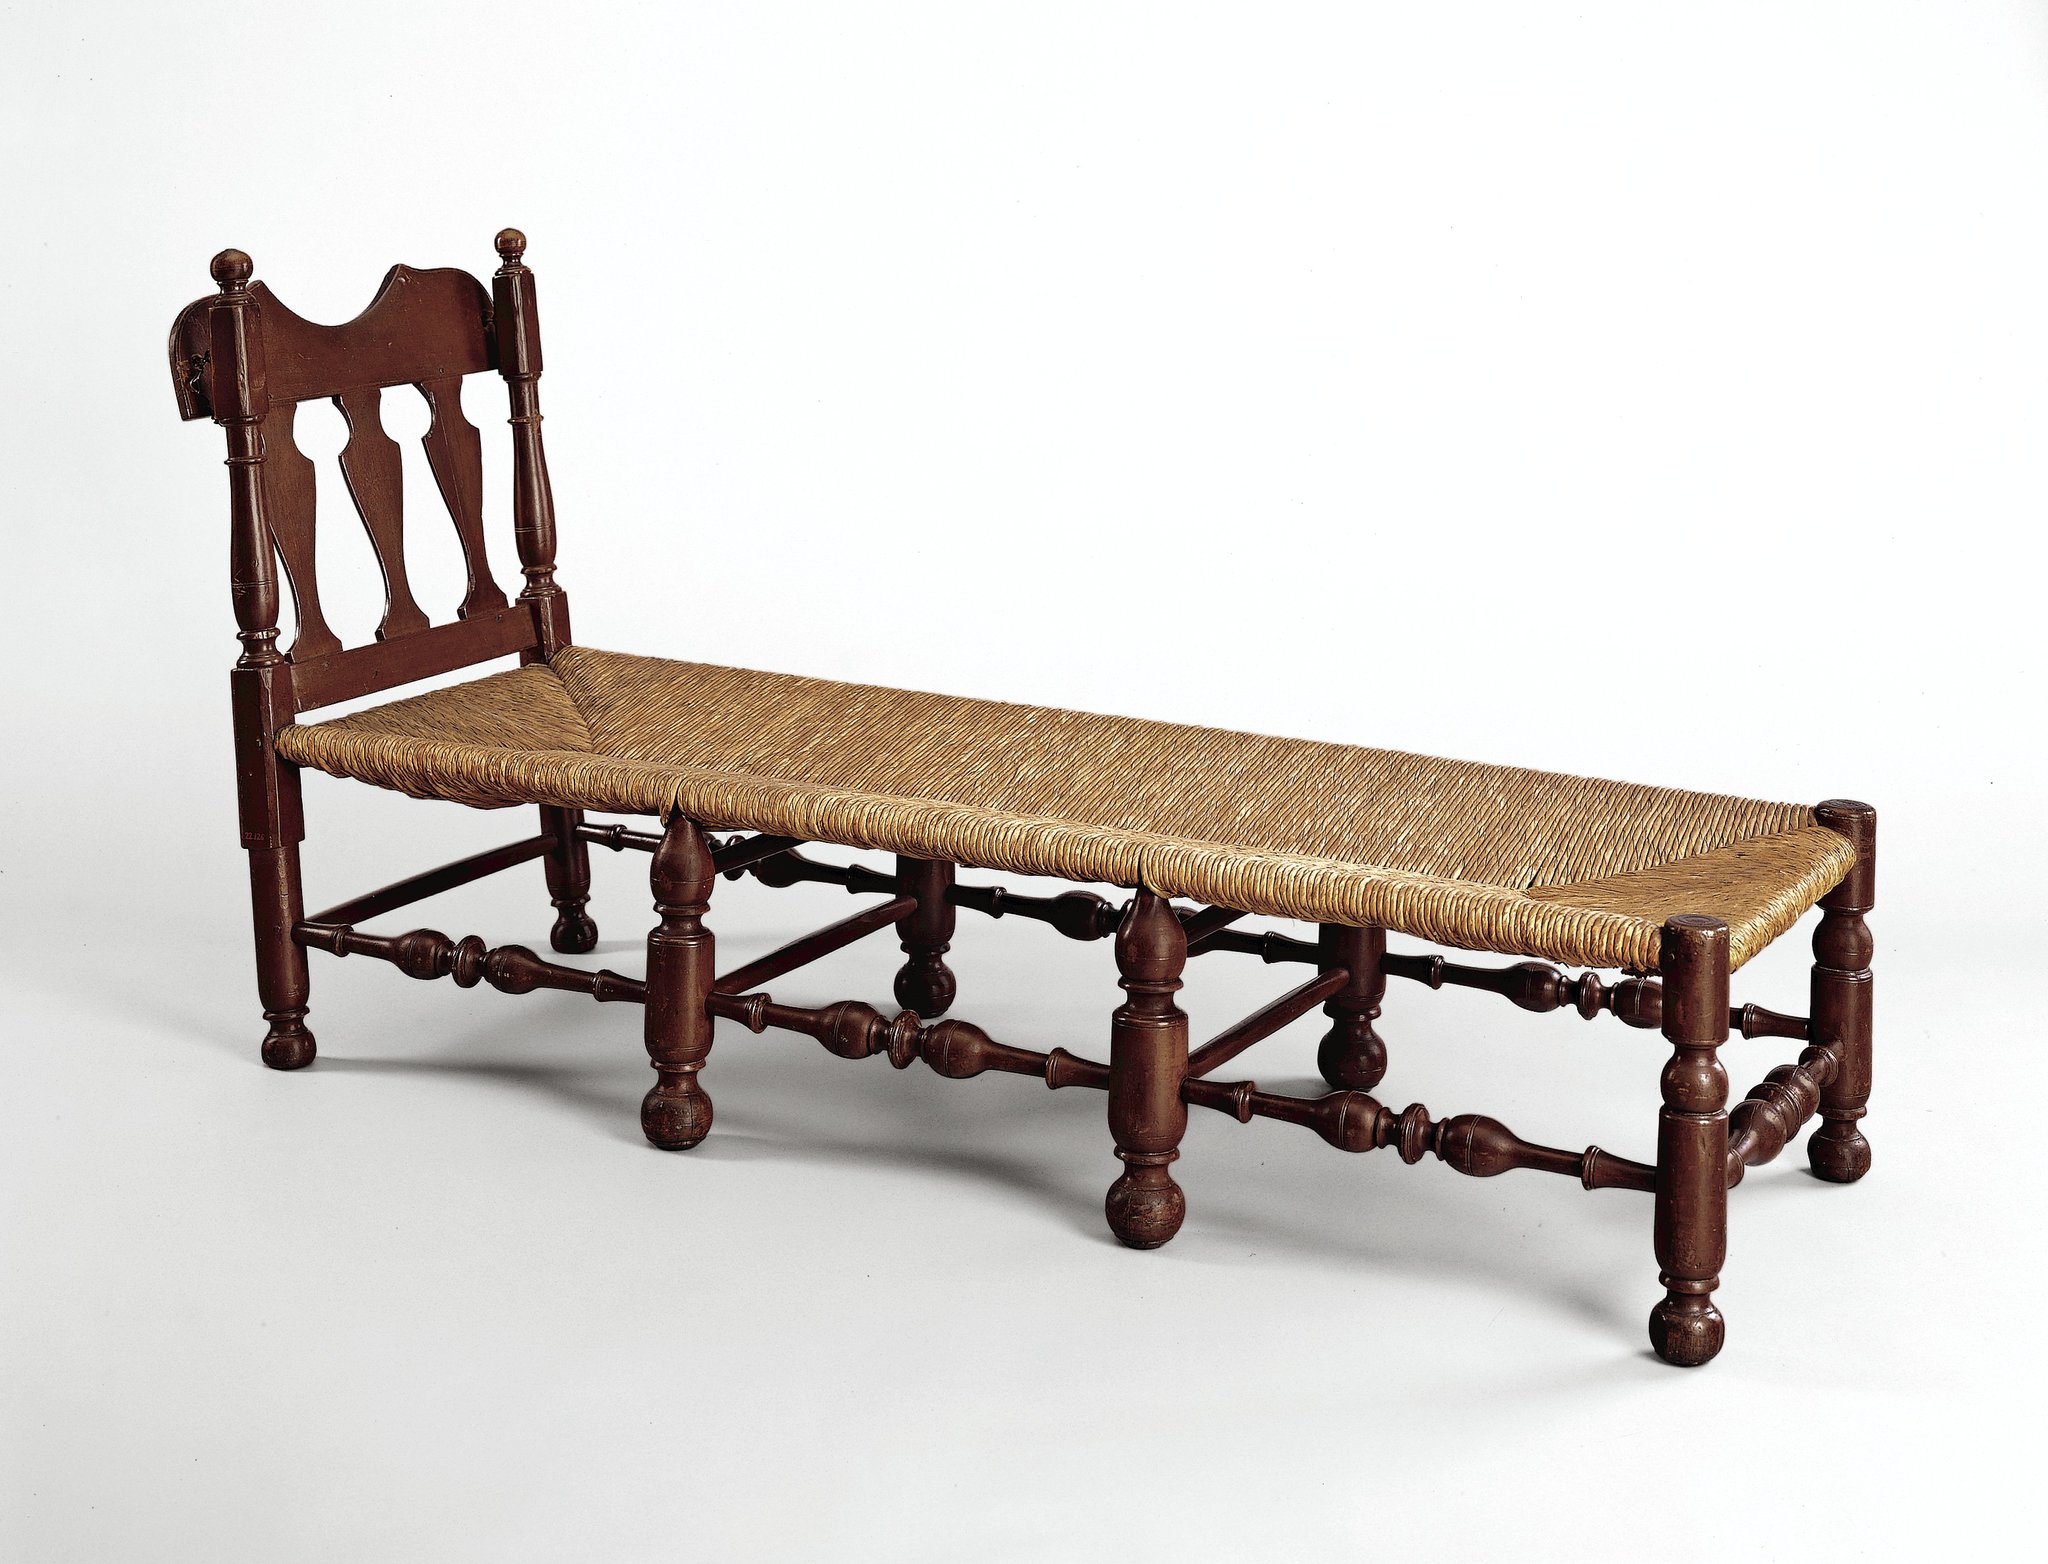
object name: daybed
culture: american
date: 1725-1750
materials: wood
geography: united states